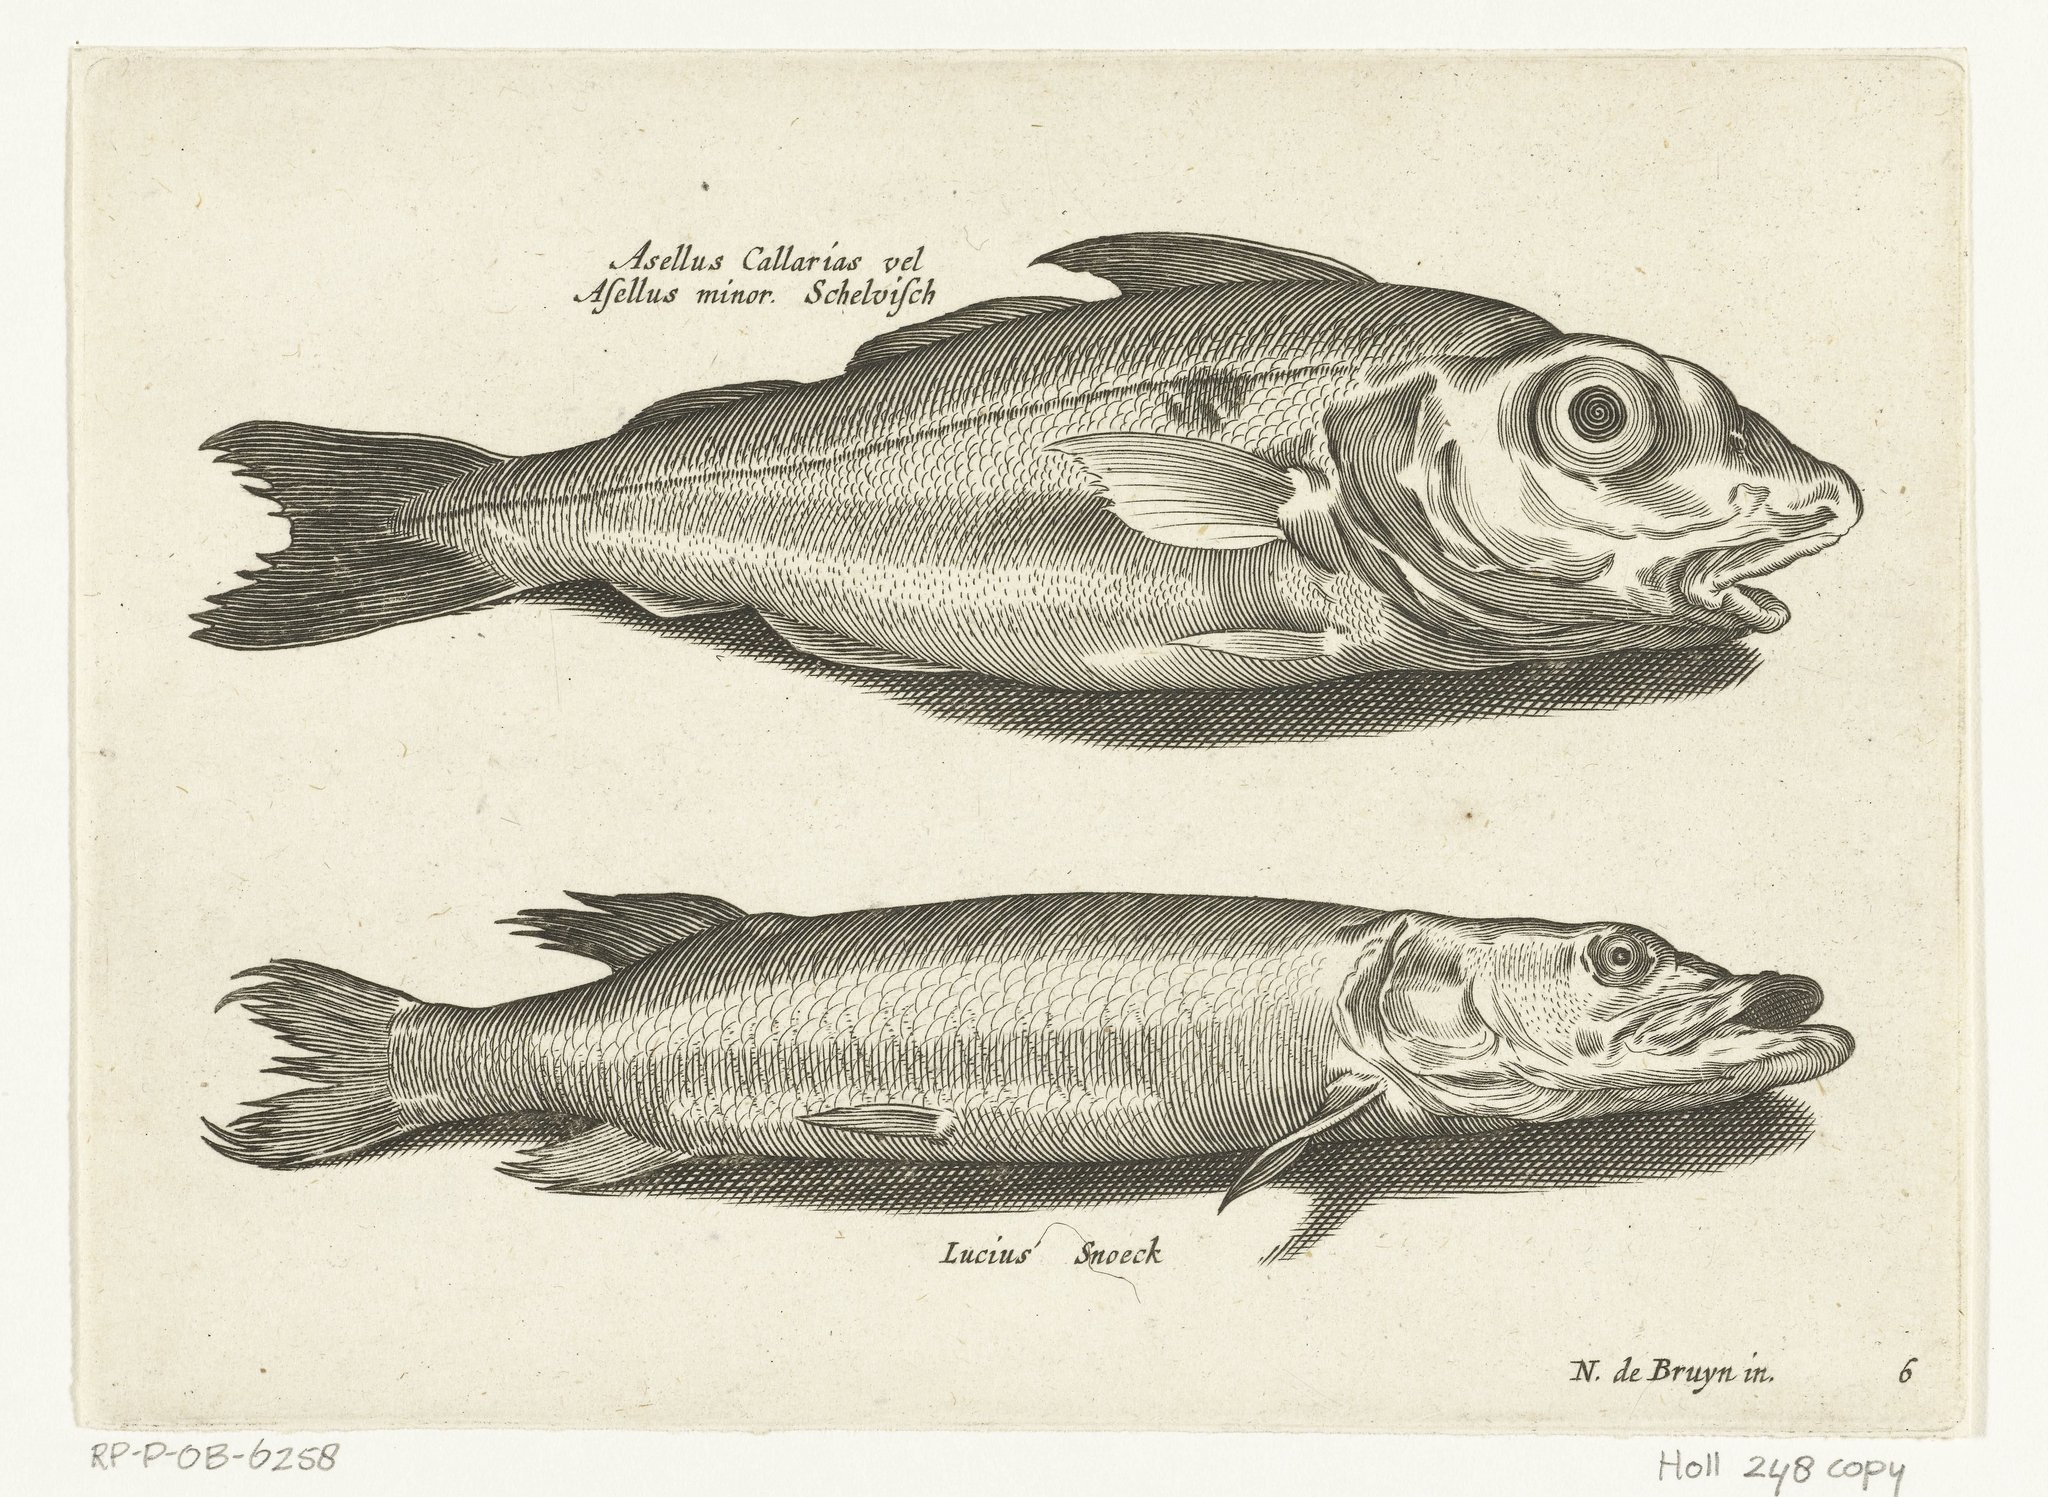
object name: print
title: Libelivs varia Genera piscium complectens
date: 1581-1656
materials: paper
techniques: engraving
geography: amsterdam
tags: fishes, bony fishes: pike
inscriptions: collector's mark: Lugt 2228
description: Kopie naar prent van Nicolaes de Bruyn. Prent uit serie Libelivs varia Genera piscium complectens van dertien prenten met zoetwatervissen, zeevissen, kikkers, schaaldieren en zeewezens (inclusief titelprent).